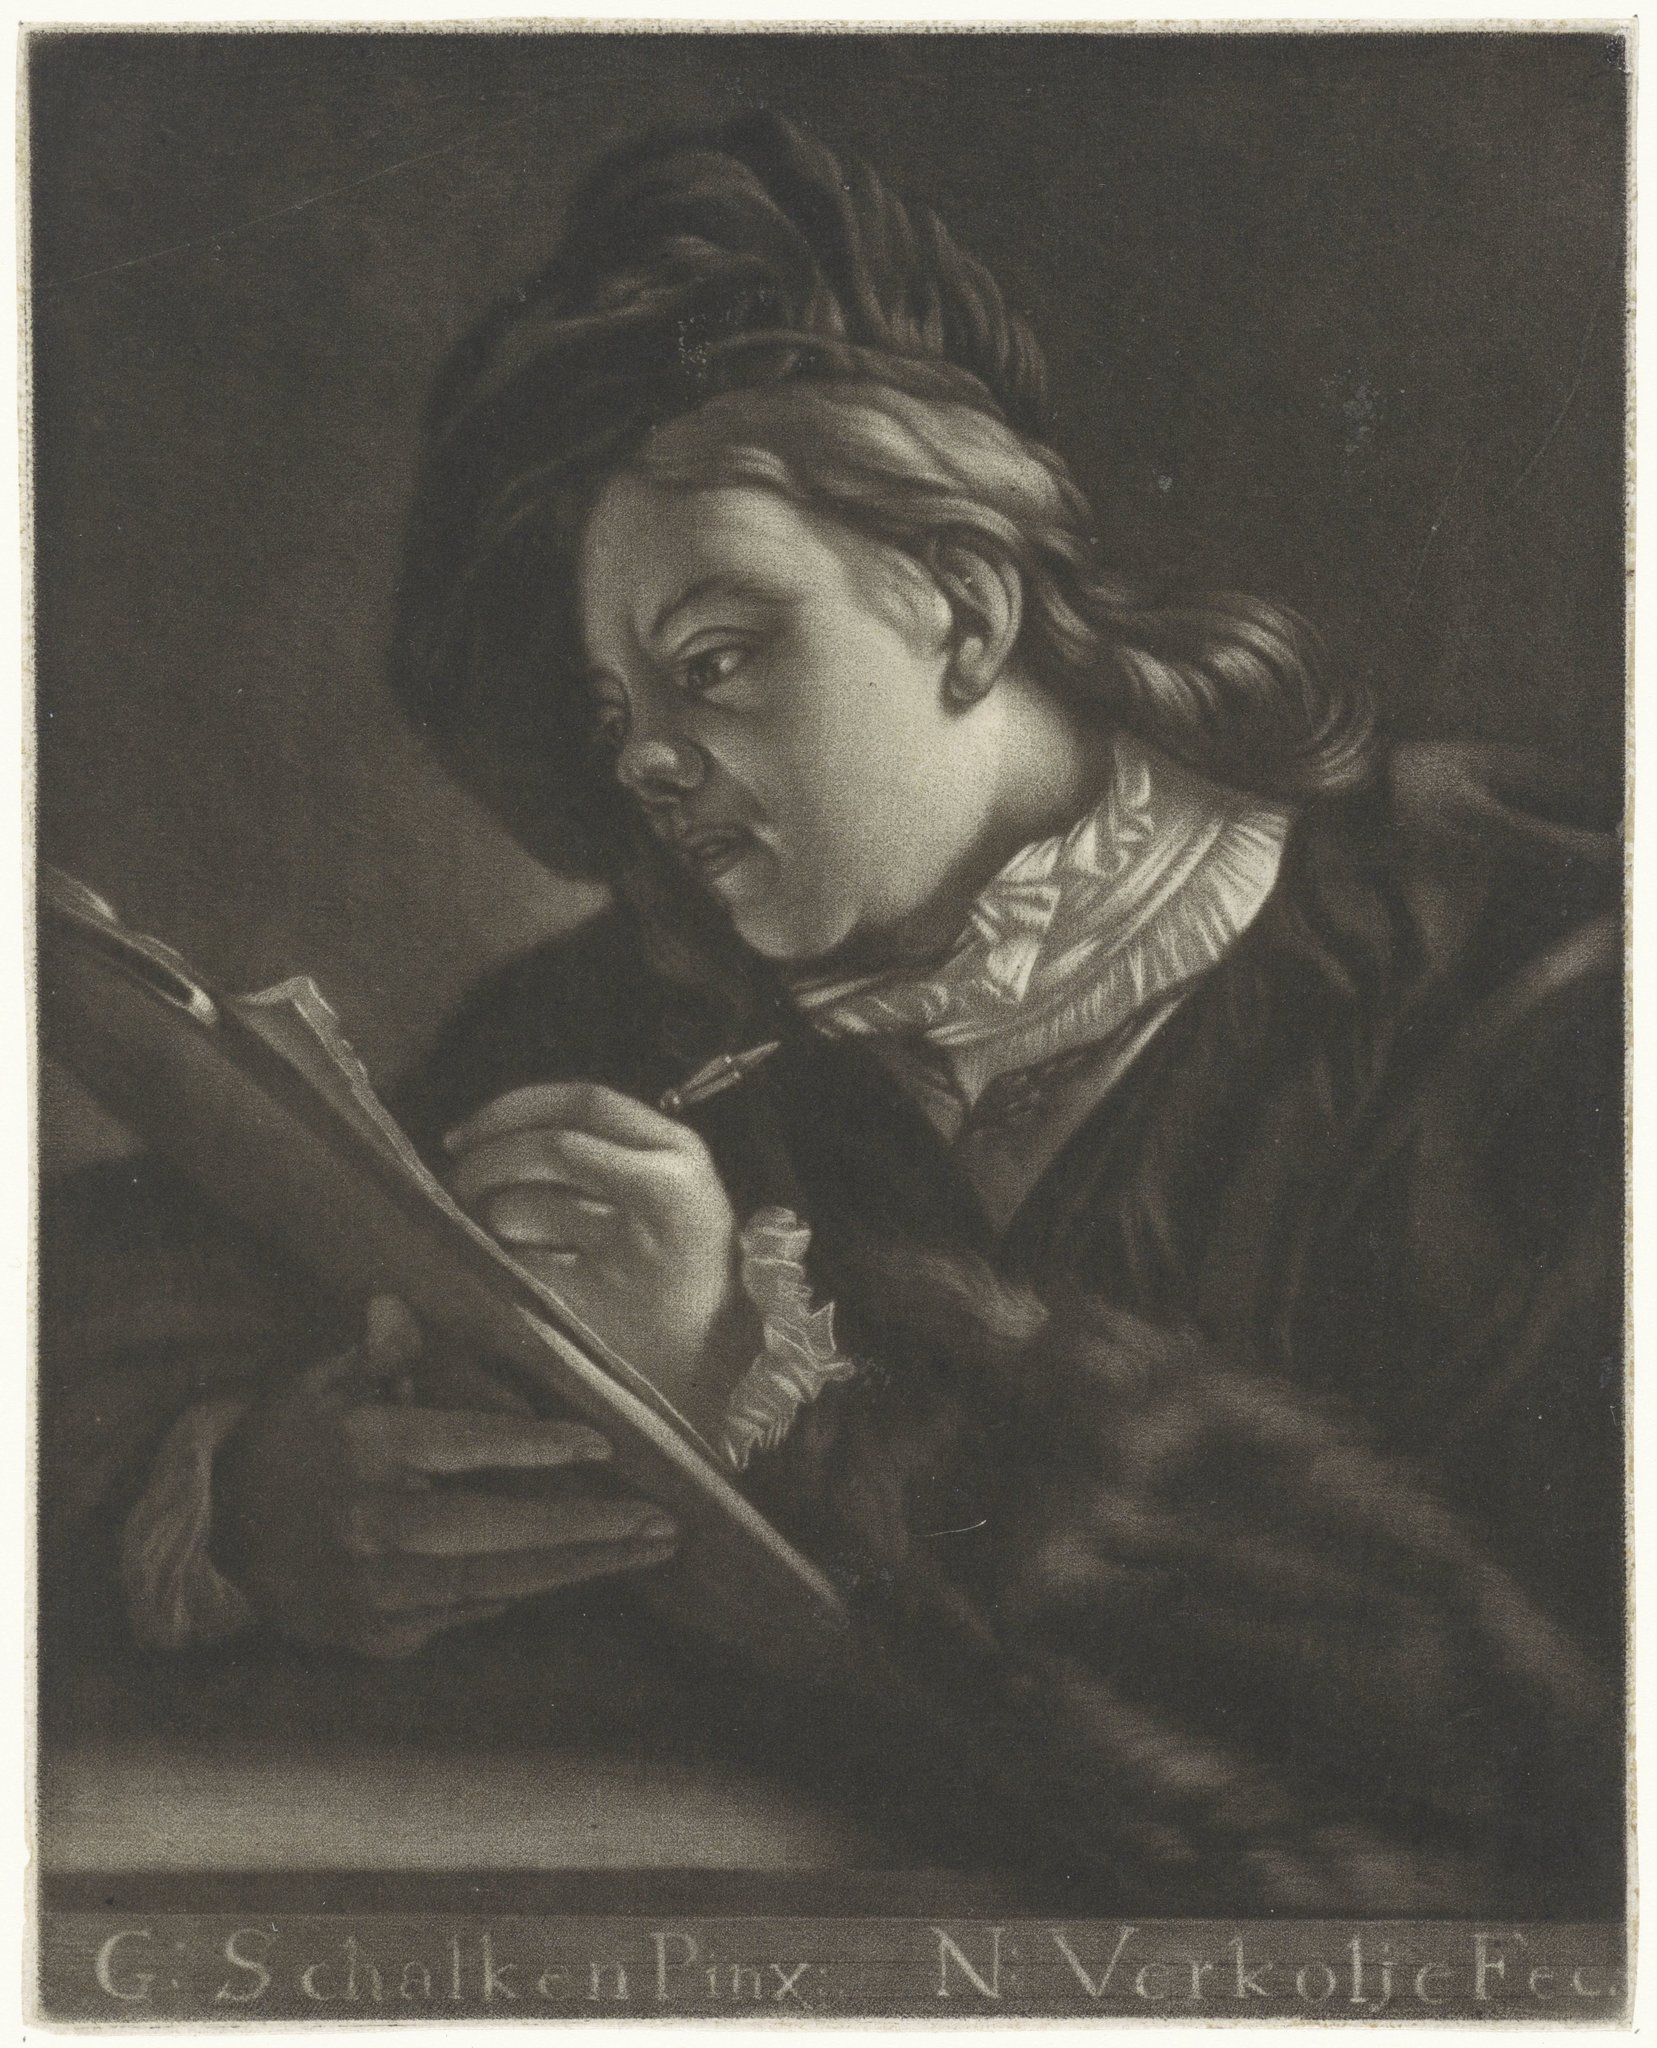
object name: print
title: Tekenaar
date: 1734-1785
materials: paper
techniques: mezzotint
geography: northern netherlands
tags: head-gear: cap (+ men's clothes), draughtsman at work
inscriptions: collector's mark: Lugt 2228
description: Een jongen tekent geconcentreerd op het blad dat hij op een plankje voor zich houdt. Hij draagt een muts.